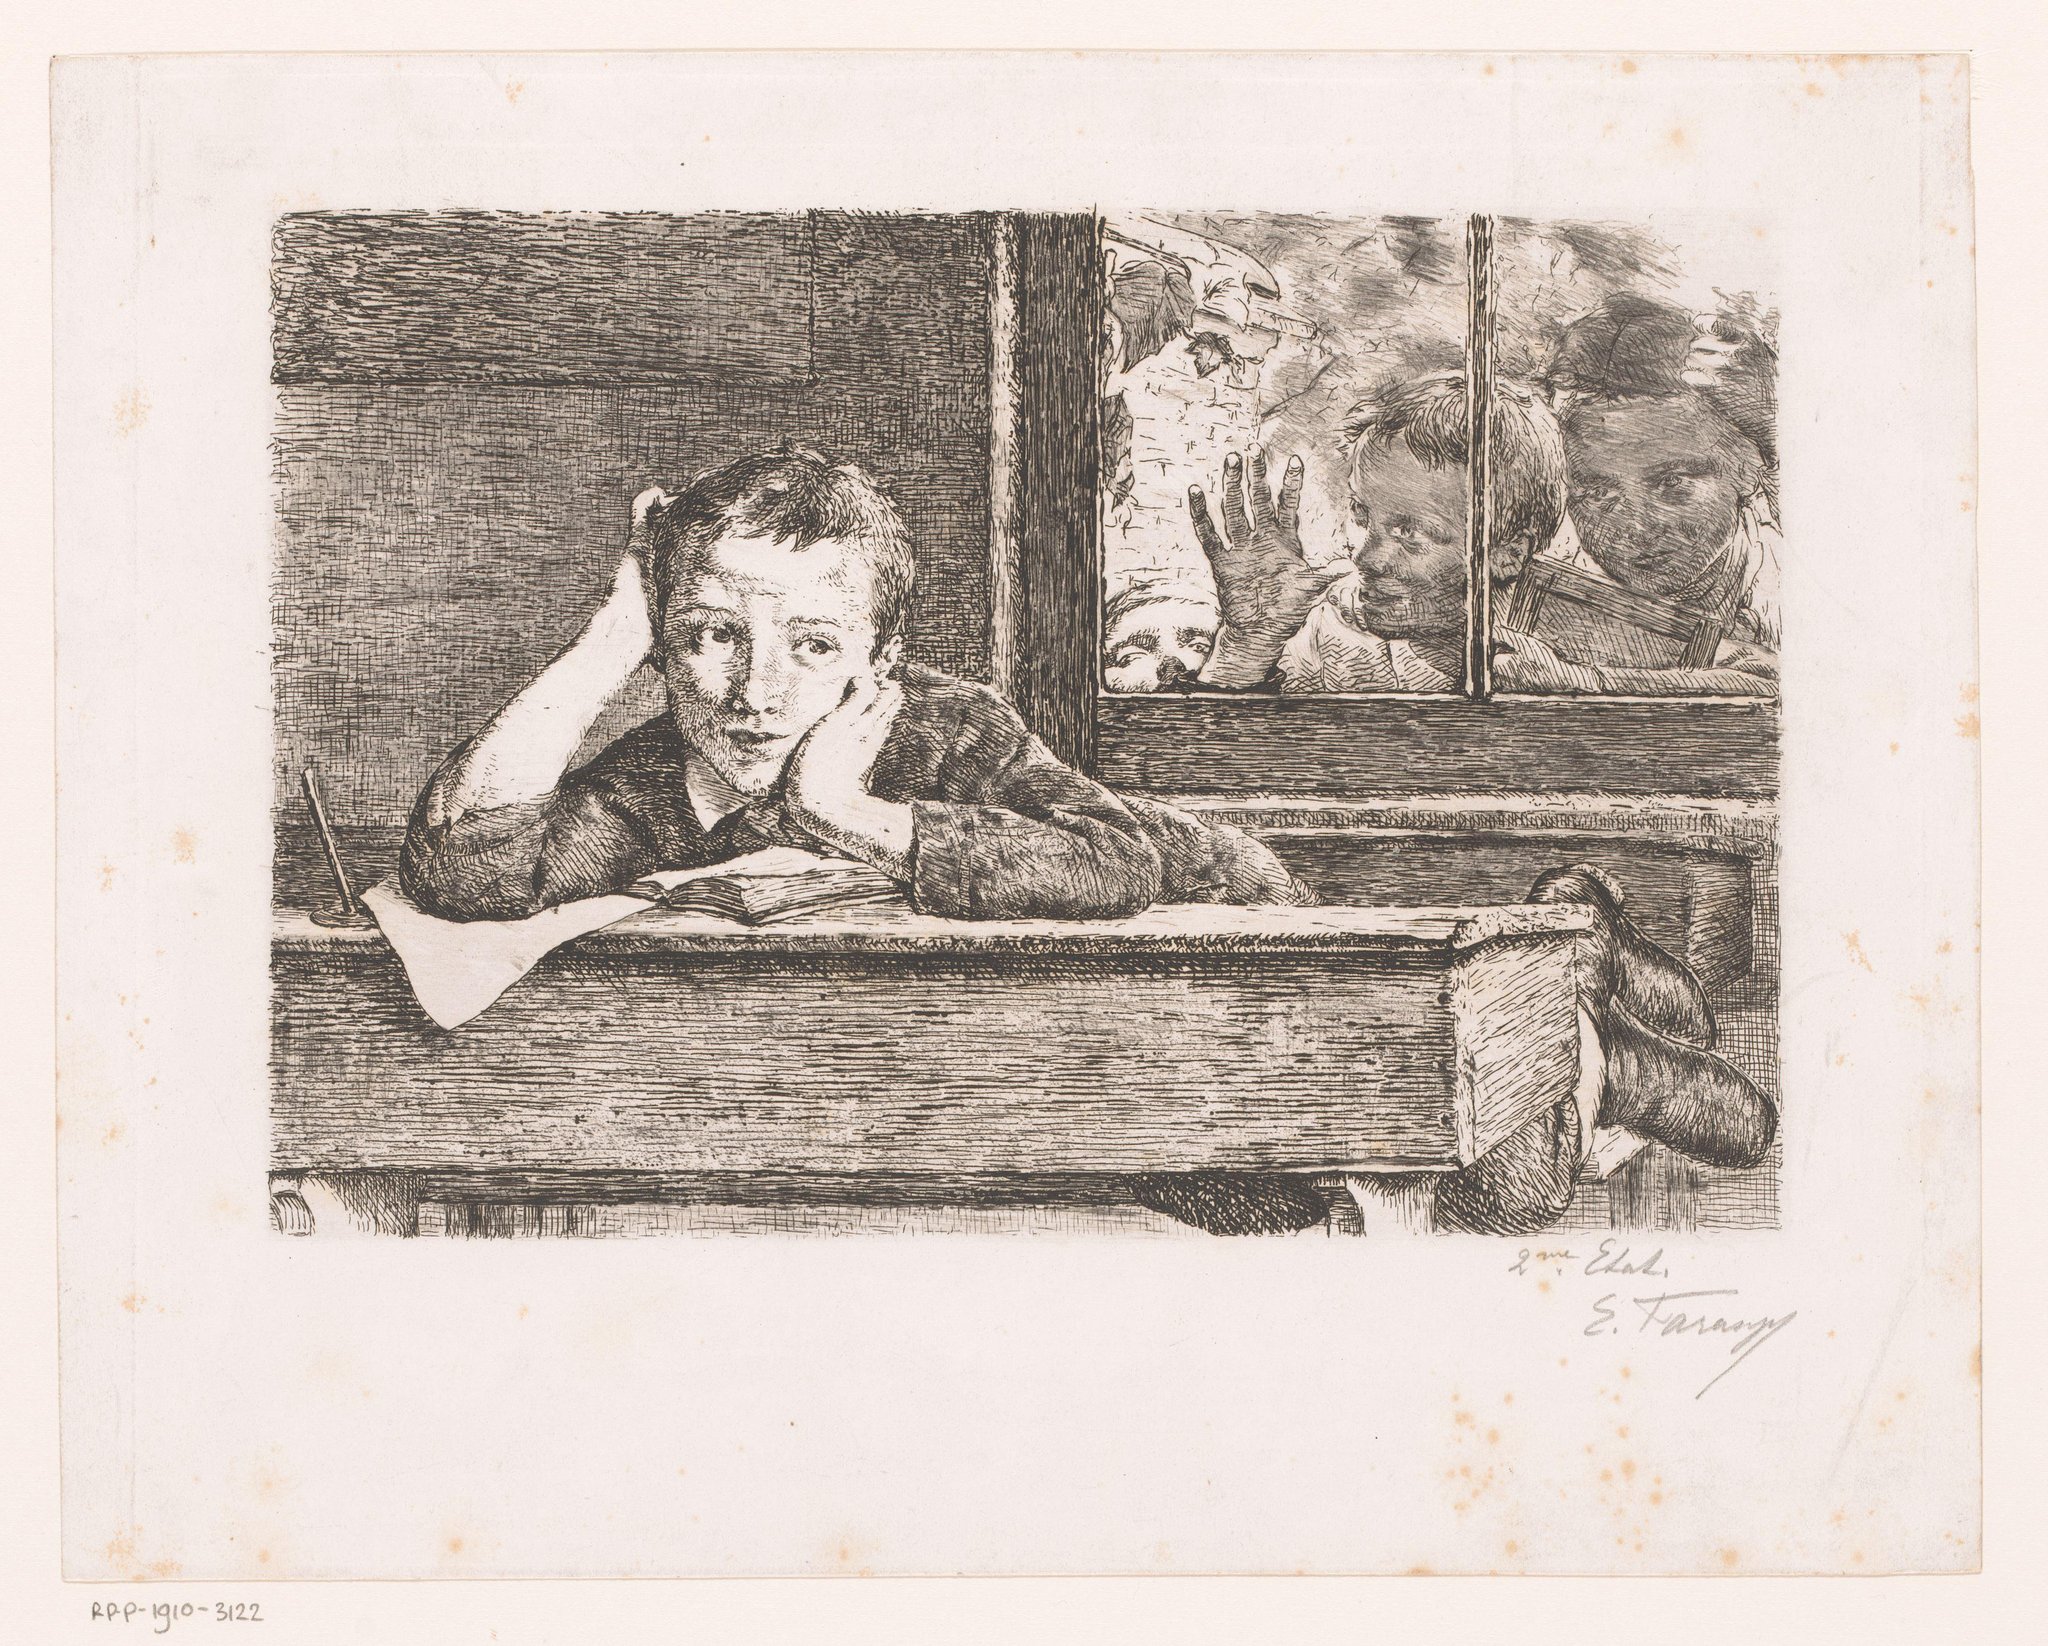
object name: print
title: Drie kinderen kijken door een raam naar een jongen die over een schoolbank hangt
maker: edgard farasyn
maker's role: print maker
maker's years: 1858-1938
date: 1868-1910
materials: paper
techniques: etching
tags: writing-table, writing-desk, child (+ four persons), closed window, elementary school; class, form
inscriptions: inscription: ‘2me Etat’, collector's mark: Lugt 2228